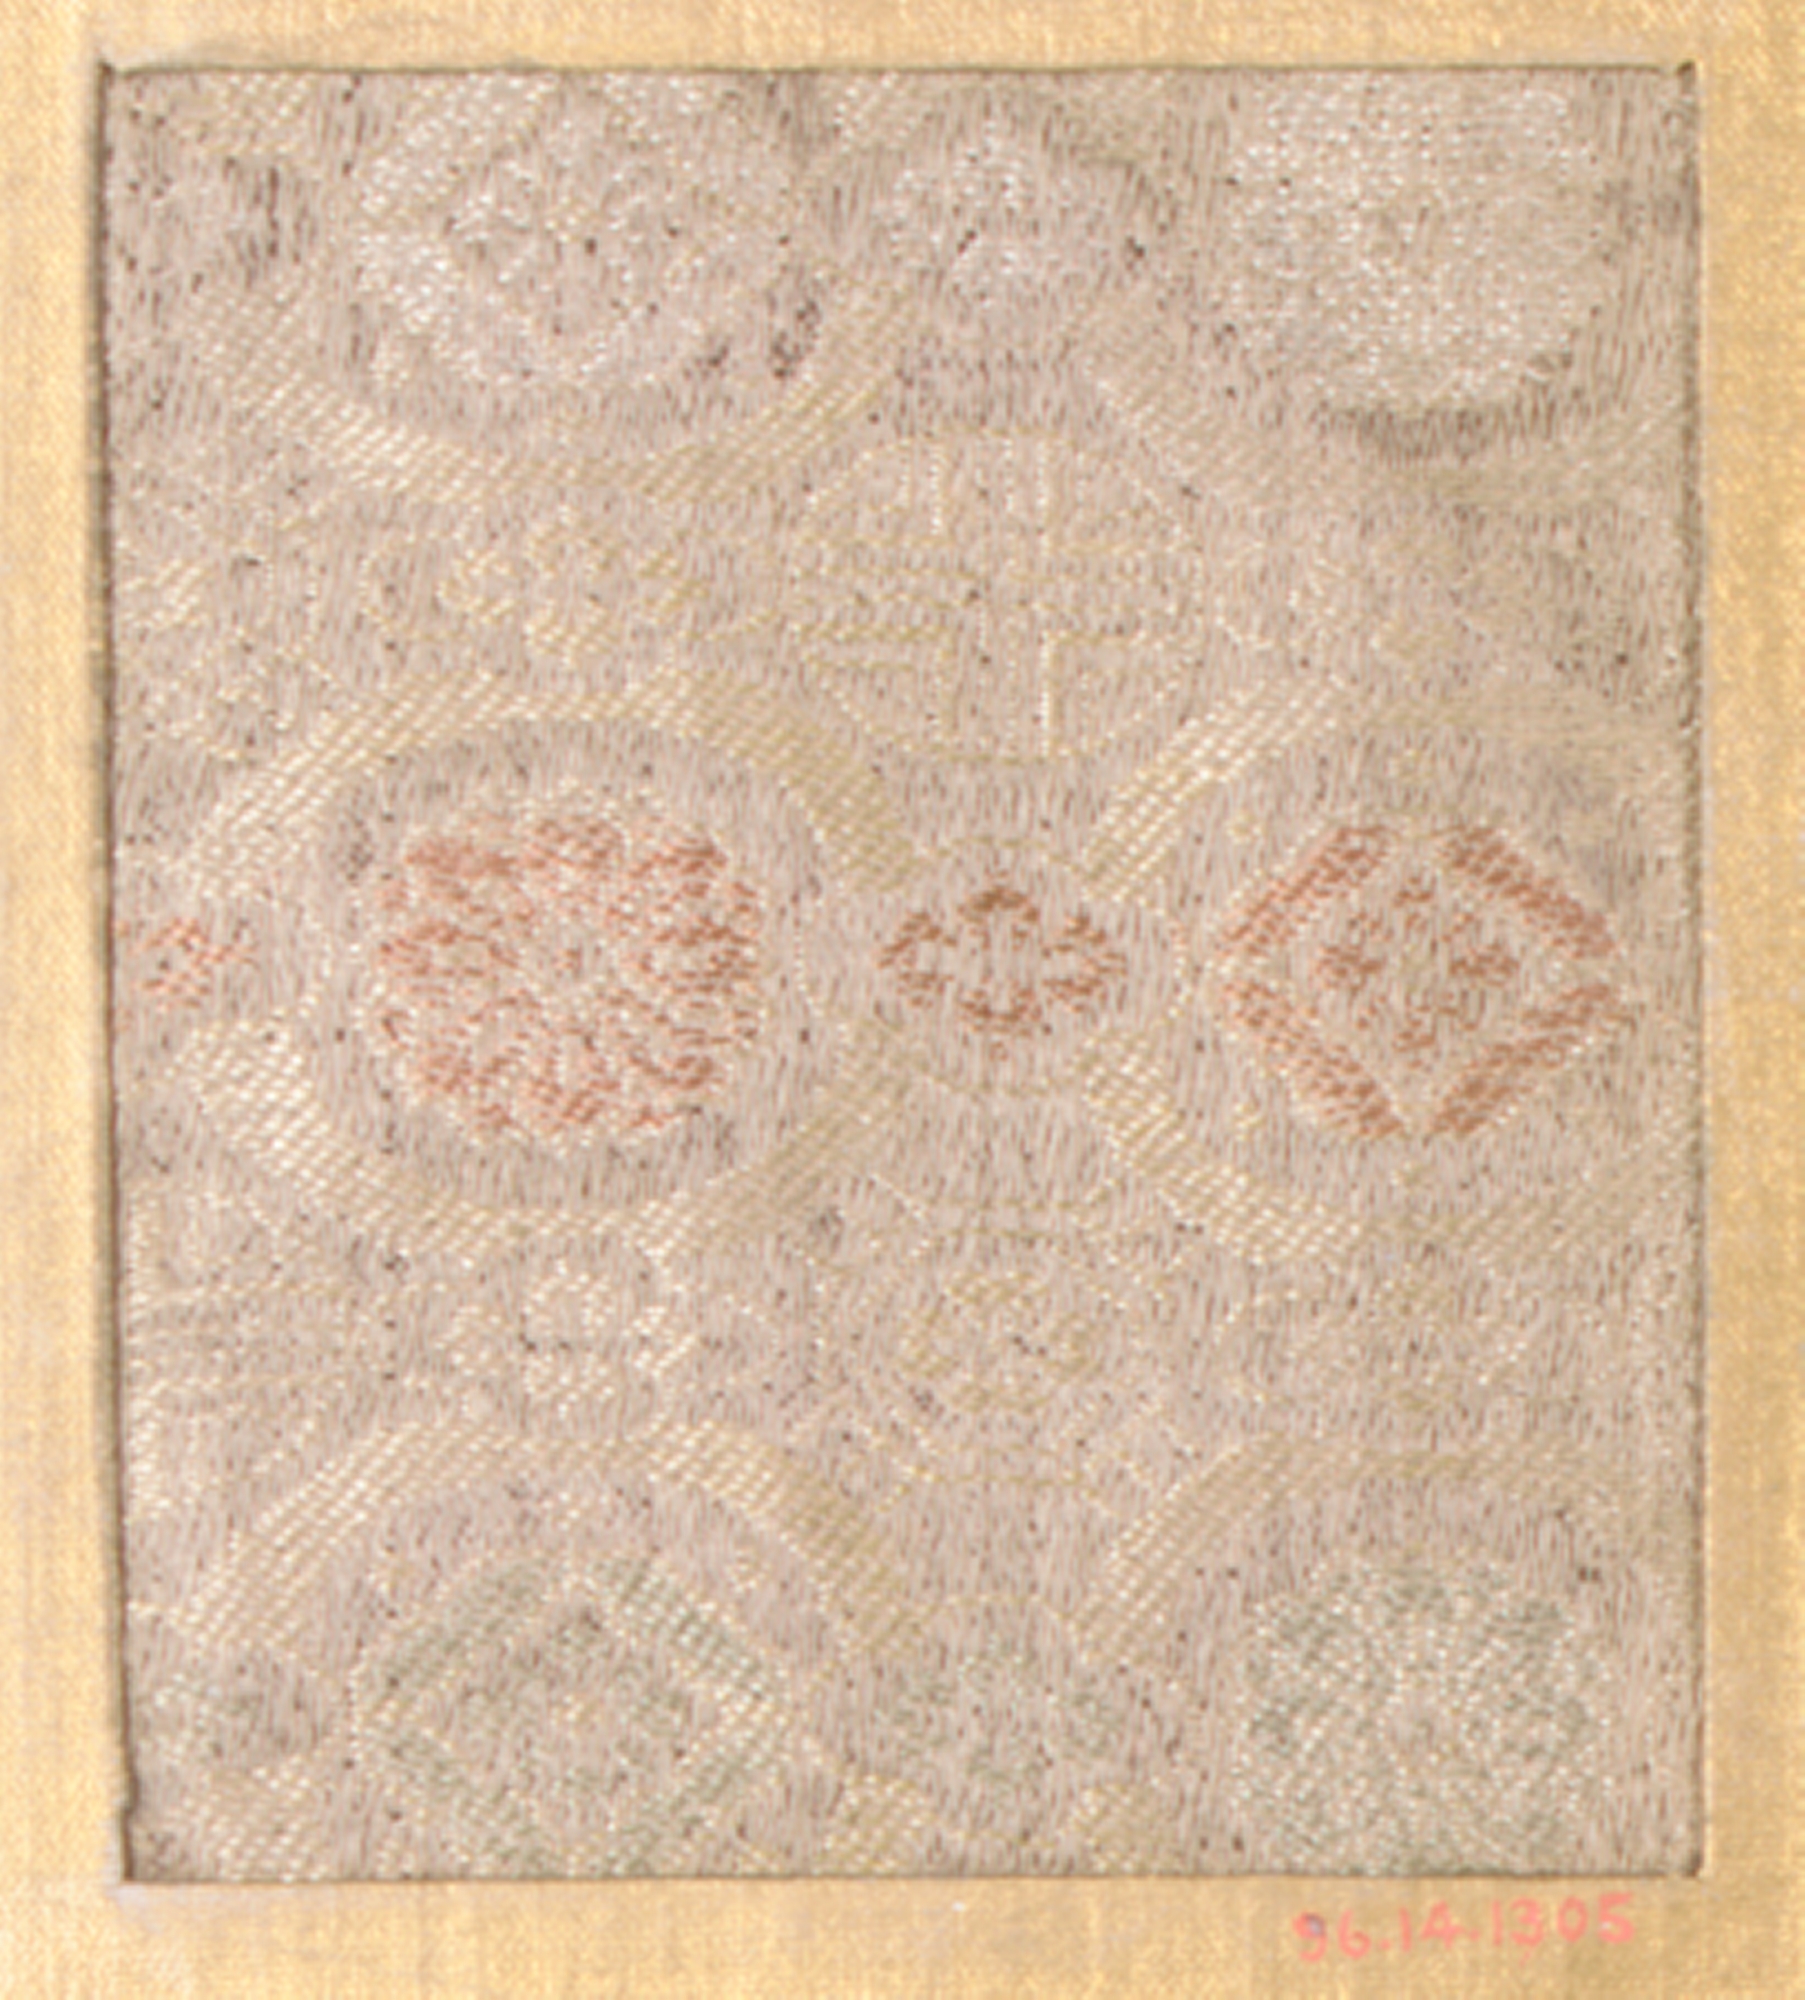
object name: piece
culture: japanese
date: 1701-1900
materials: silk